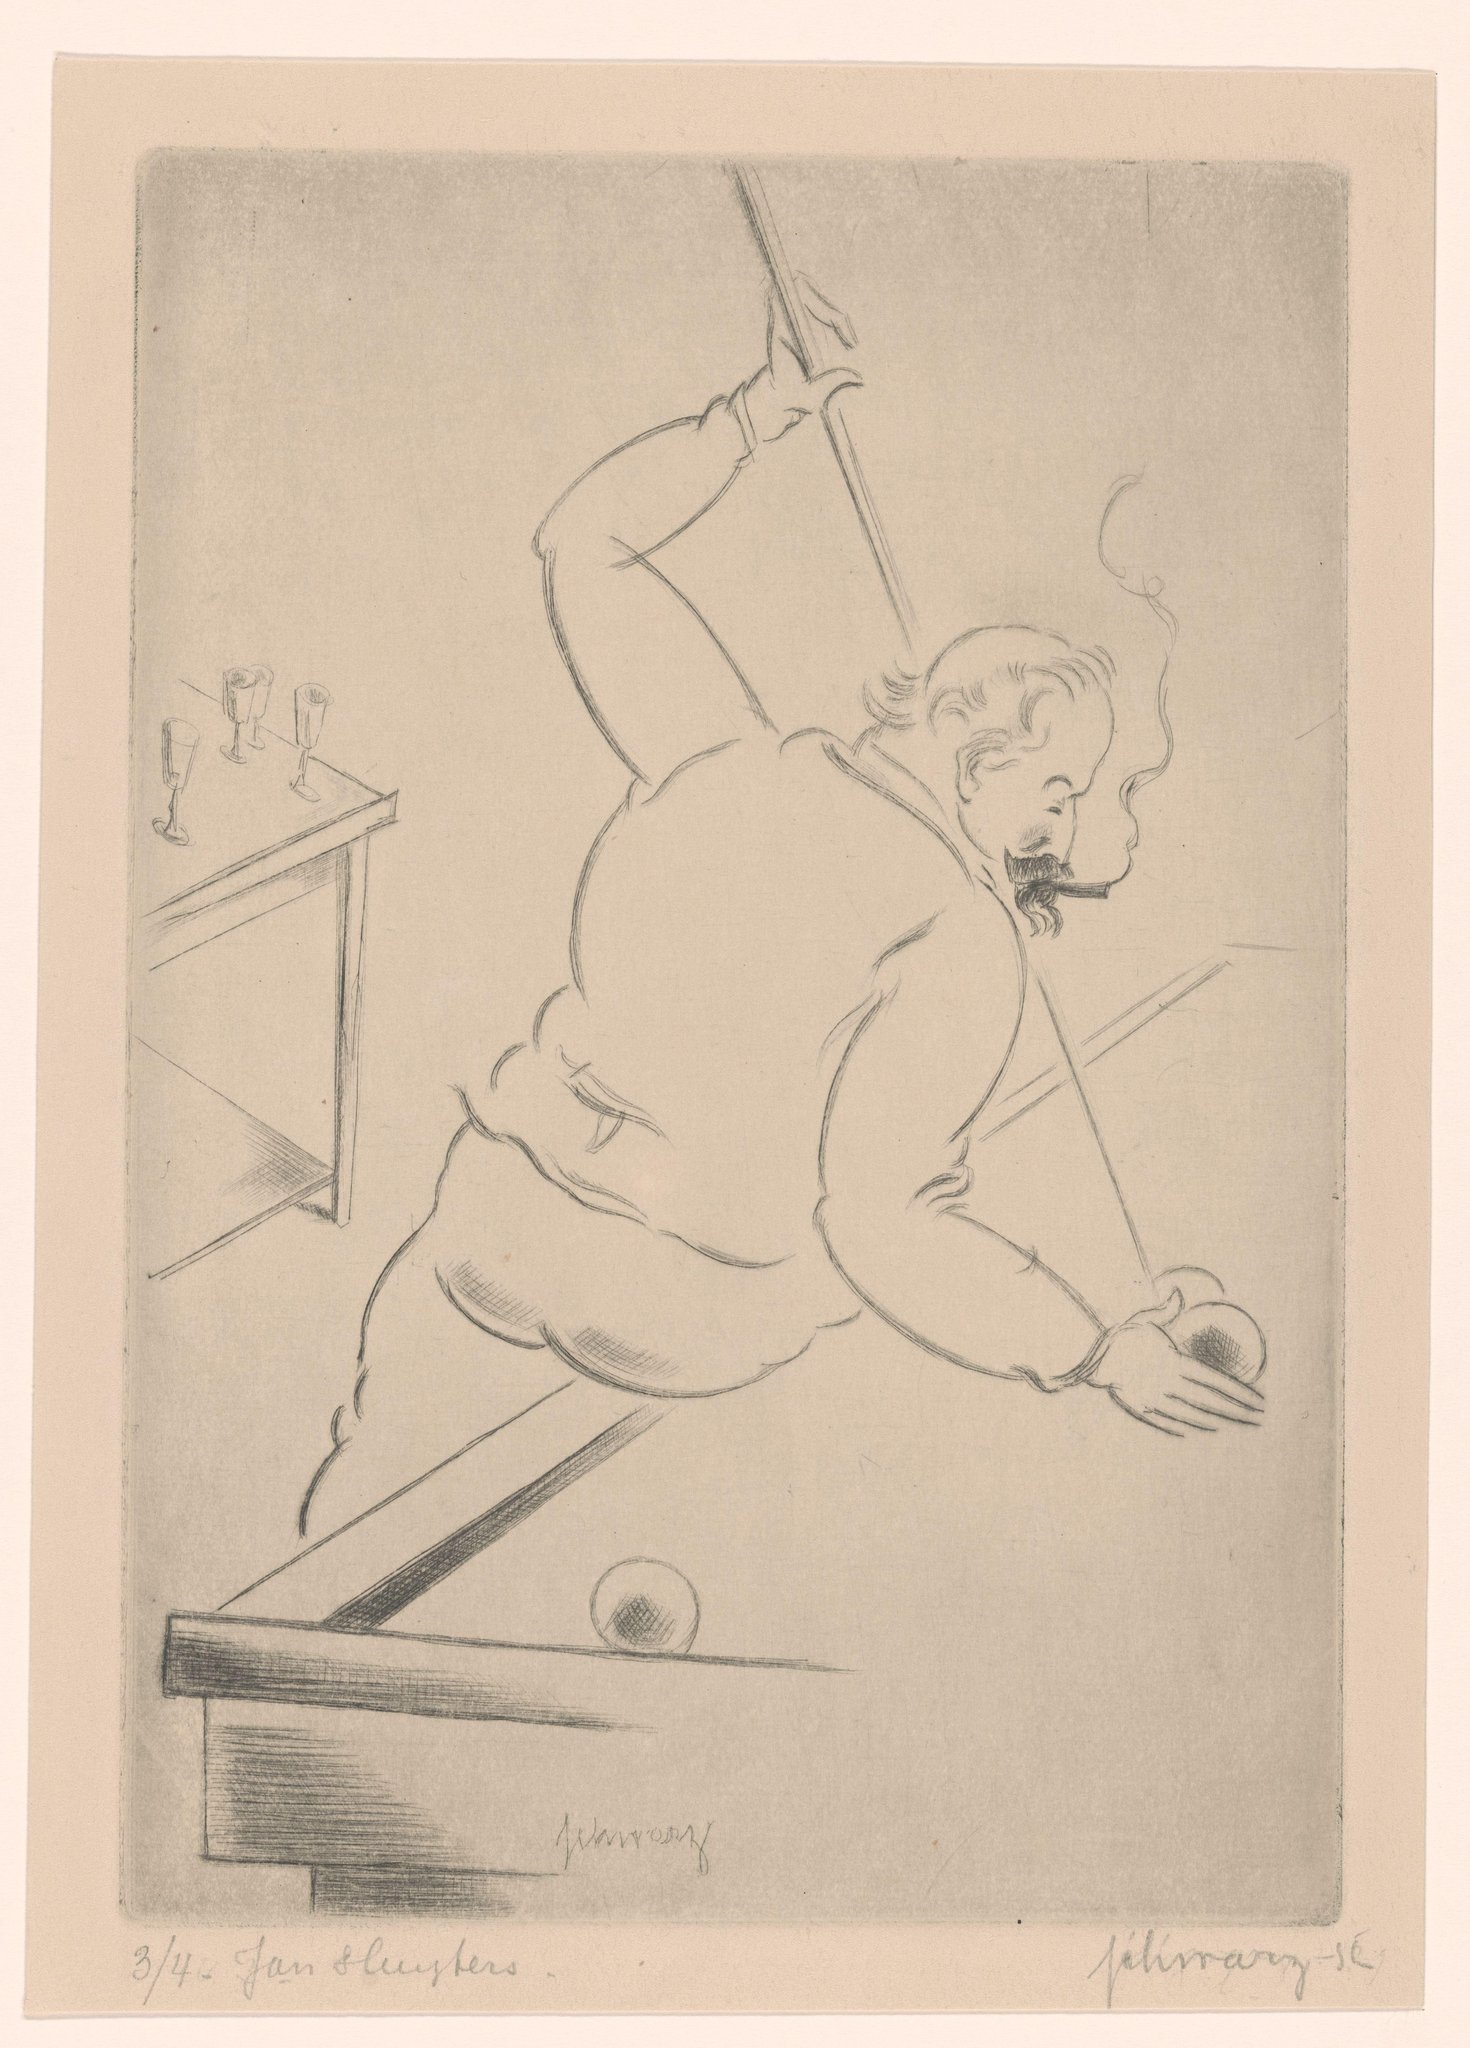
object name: print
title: Jan Sluyters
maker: mommie schwarz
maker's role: print maker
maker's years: 1876-1942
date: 1886-1931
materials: paper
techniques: drypoint, intaglio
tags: den bosch, print maker, draughtsman, jan sluijters, billiards, portrait, self-portrait of artist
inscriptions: collector's mark: Lugt 2228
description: Jan Sluijters zit met sigaar in de mond op een biljarttafel. In zijn linkerhand houdt hij een keu; met zijn rechterhand legt hij twee ballen neer.